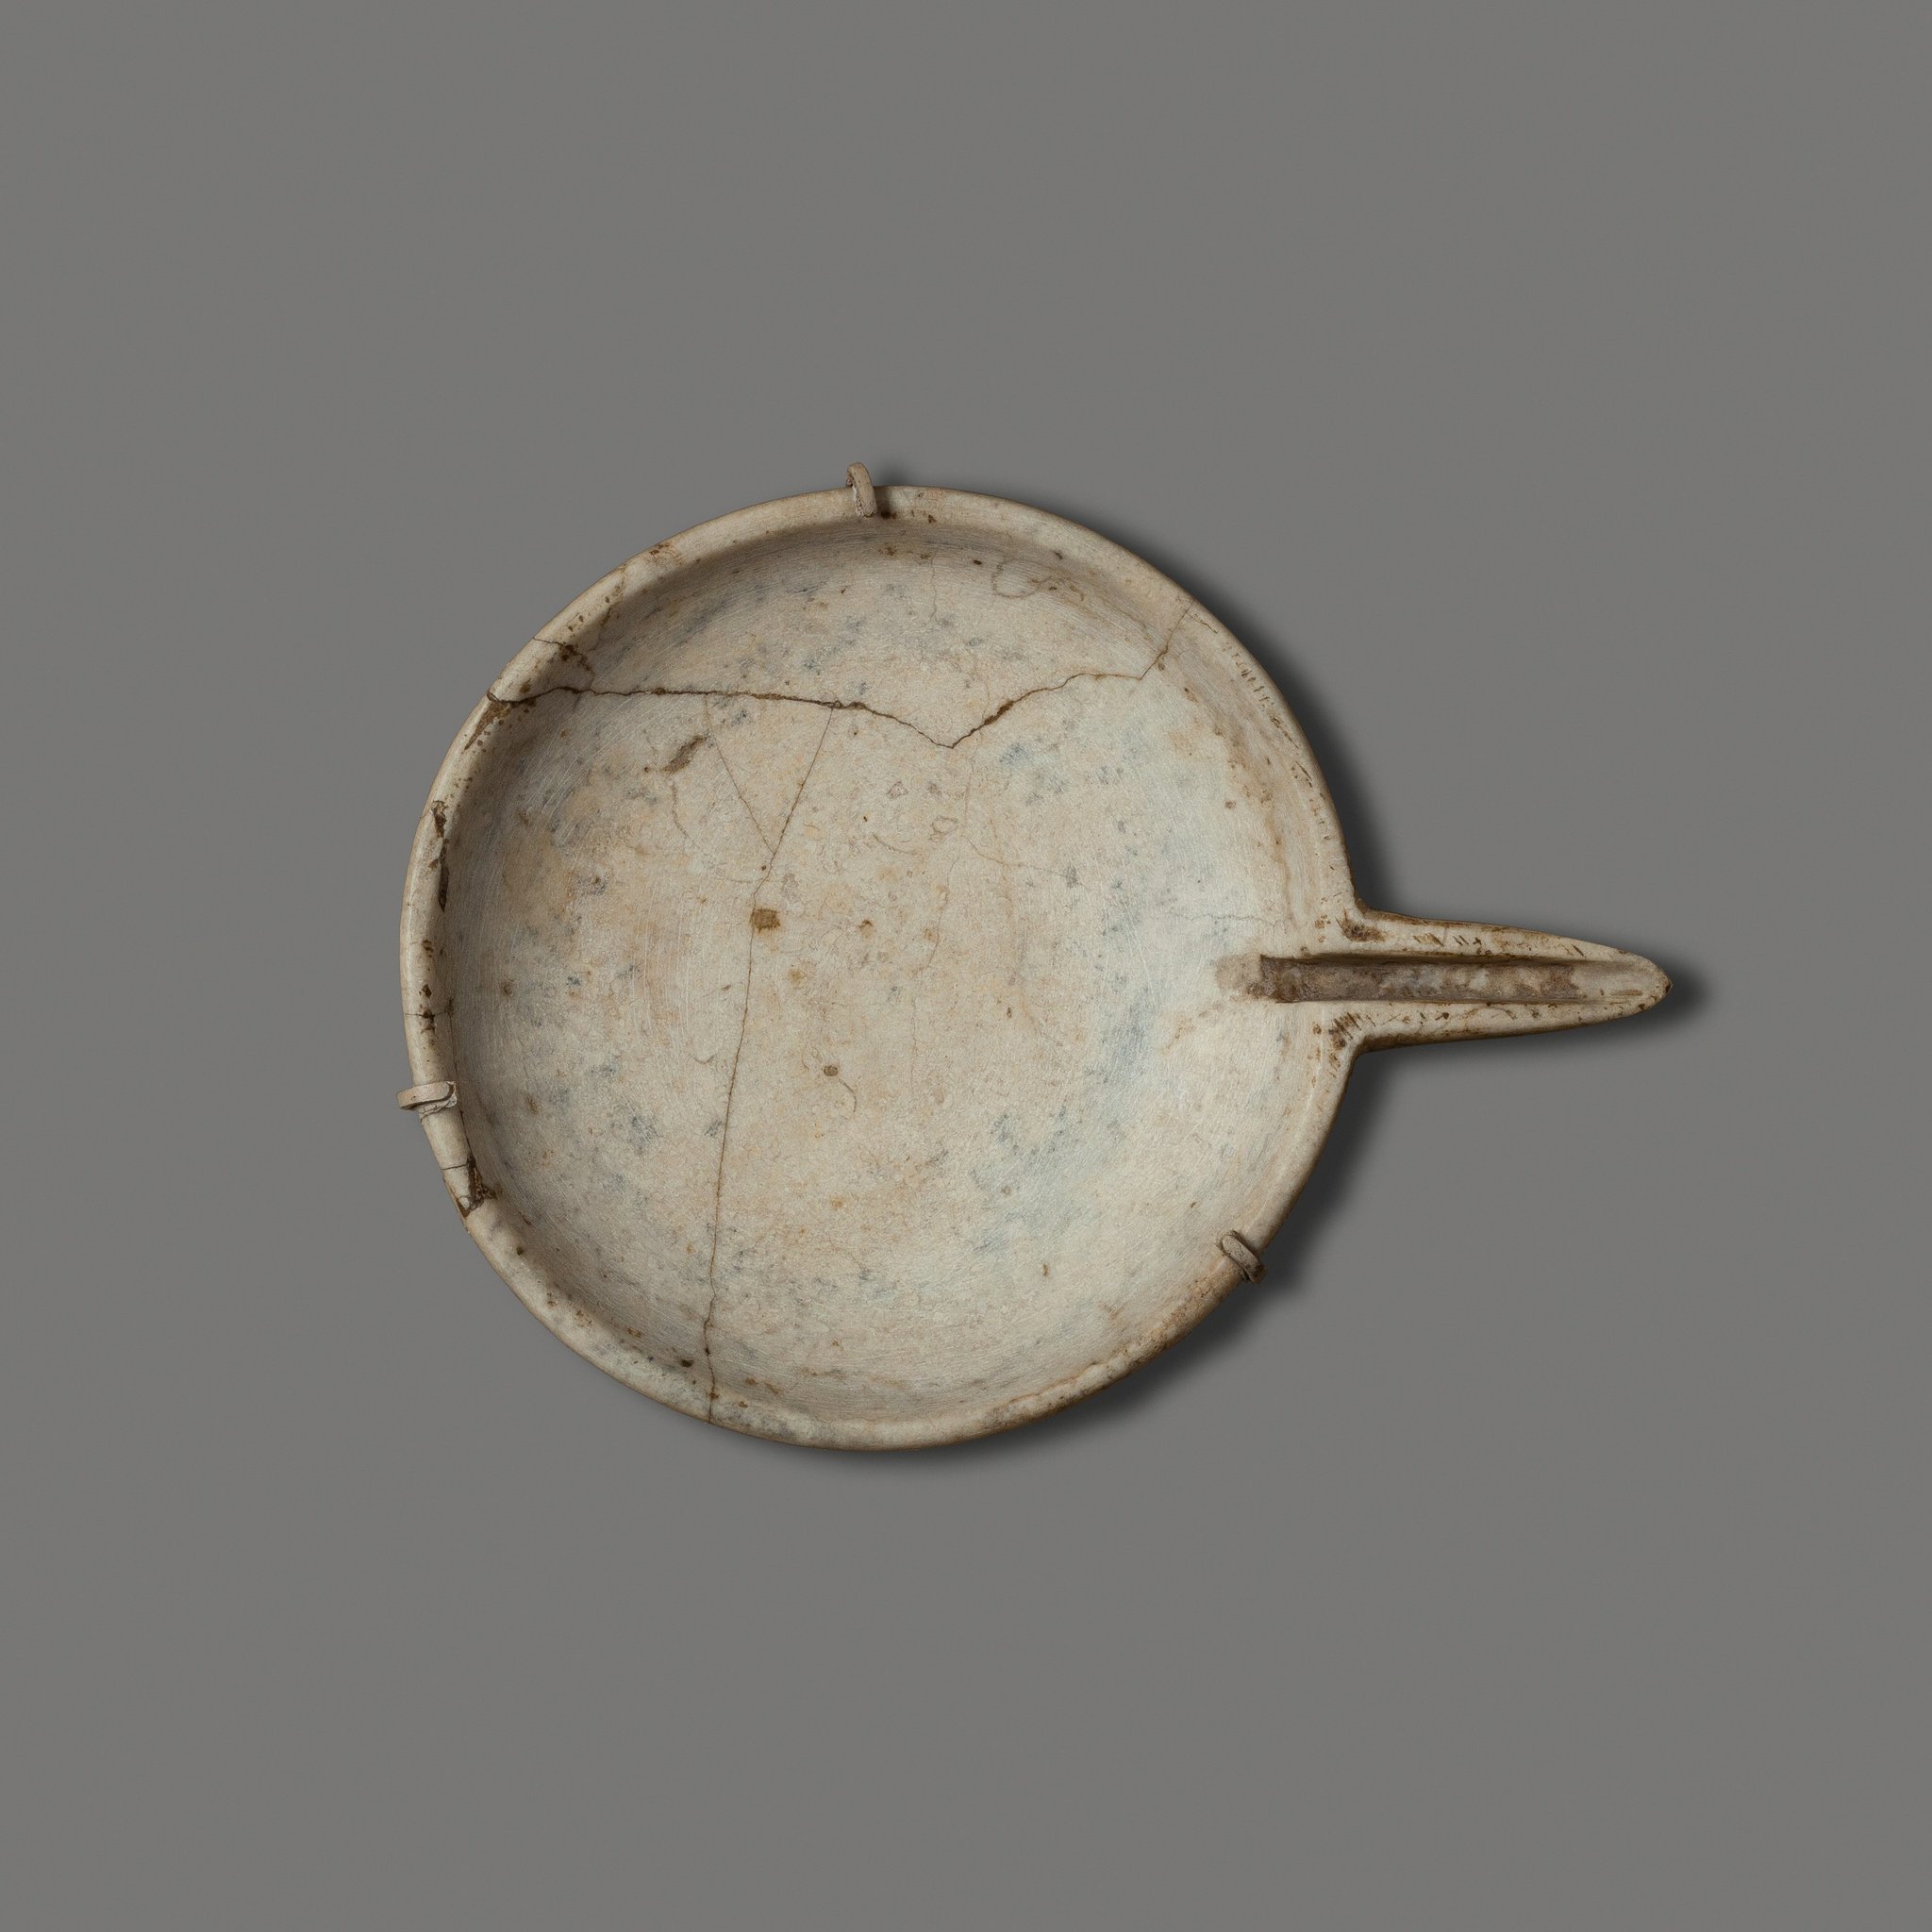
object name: cup, spouted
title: Drinking Cup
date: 2649-2465 BCE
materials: limestone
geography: egypt